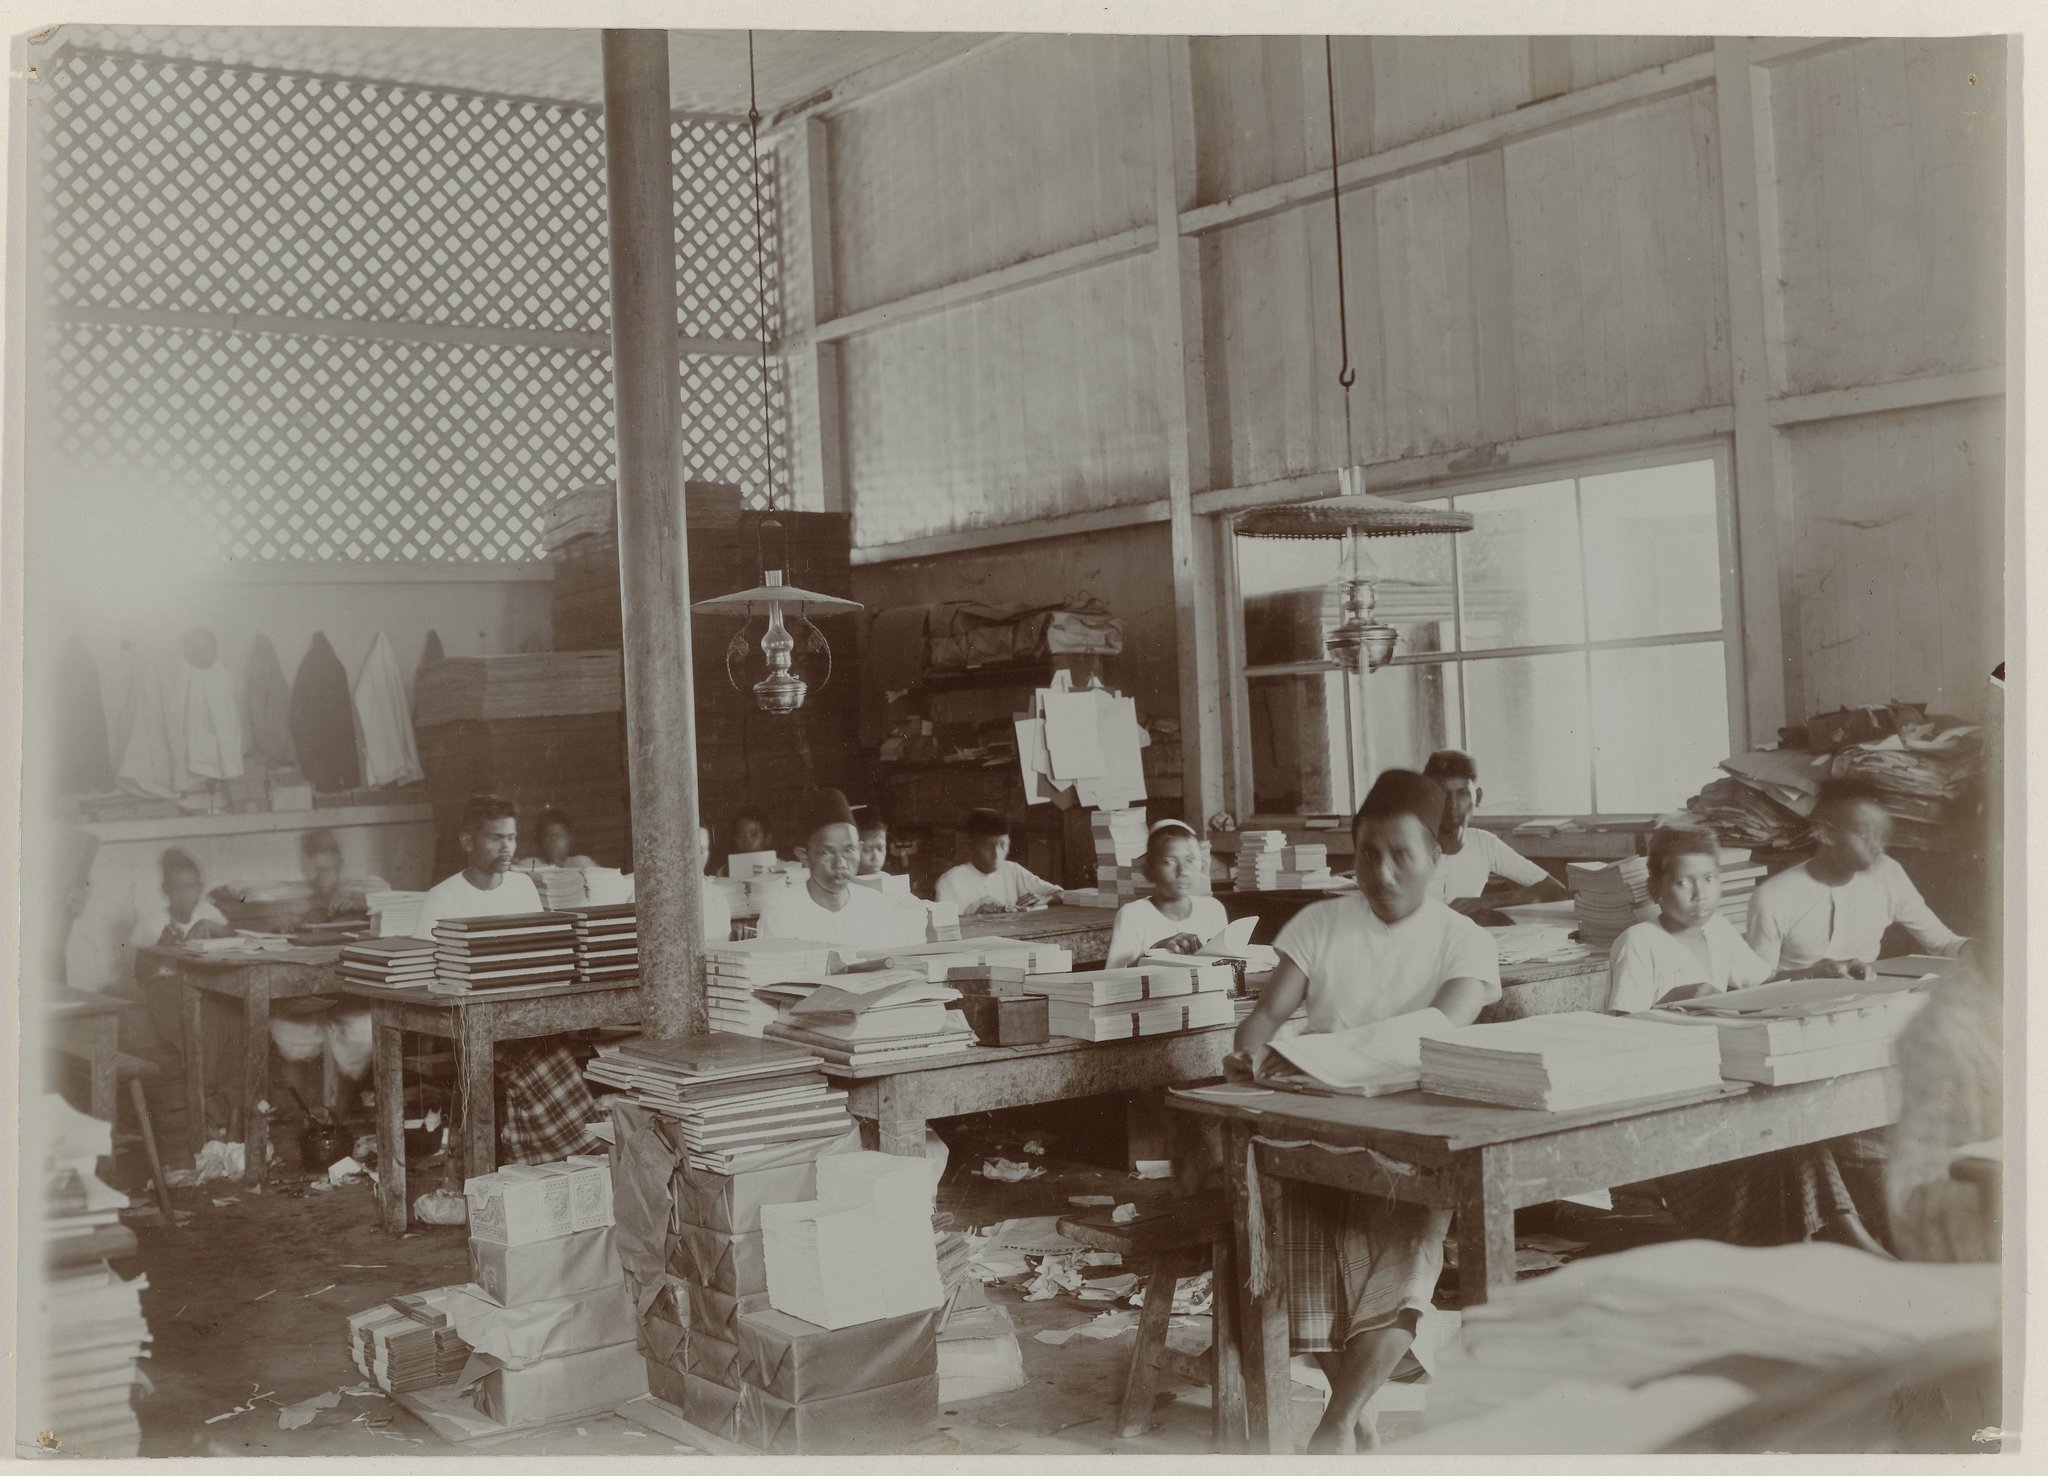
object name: photograph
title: Binderij van de Deli Courant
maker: Anonymous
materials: photographic support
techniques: collodion silver print, gelatin silver print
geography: medan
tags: dutch east indies, the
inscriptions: inscription: ‘binderij’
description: Gezicht in de binderij van de drukkerij van de Deli Courant te Medan, met Javaanse werknemers zittend achter werktafels. Onderdeel van een aparte groep van negen foto's uit 1908 binnen de gehele groep van 49 losse zwart-wit foto's van verschillend formaat over de uitgeverij en drukkerij van de krant Deli Courant in Medan in de periode 1885-1947.